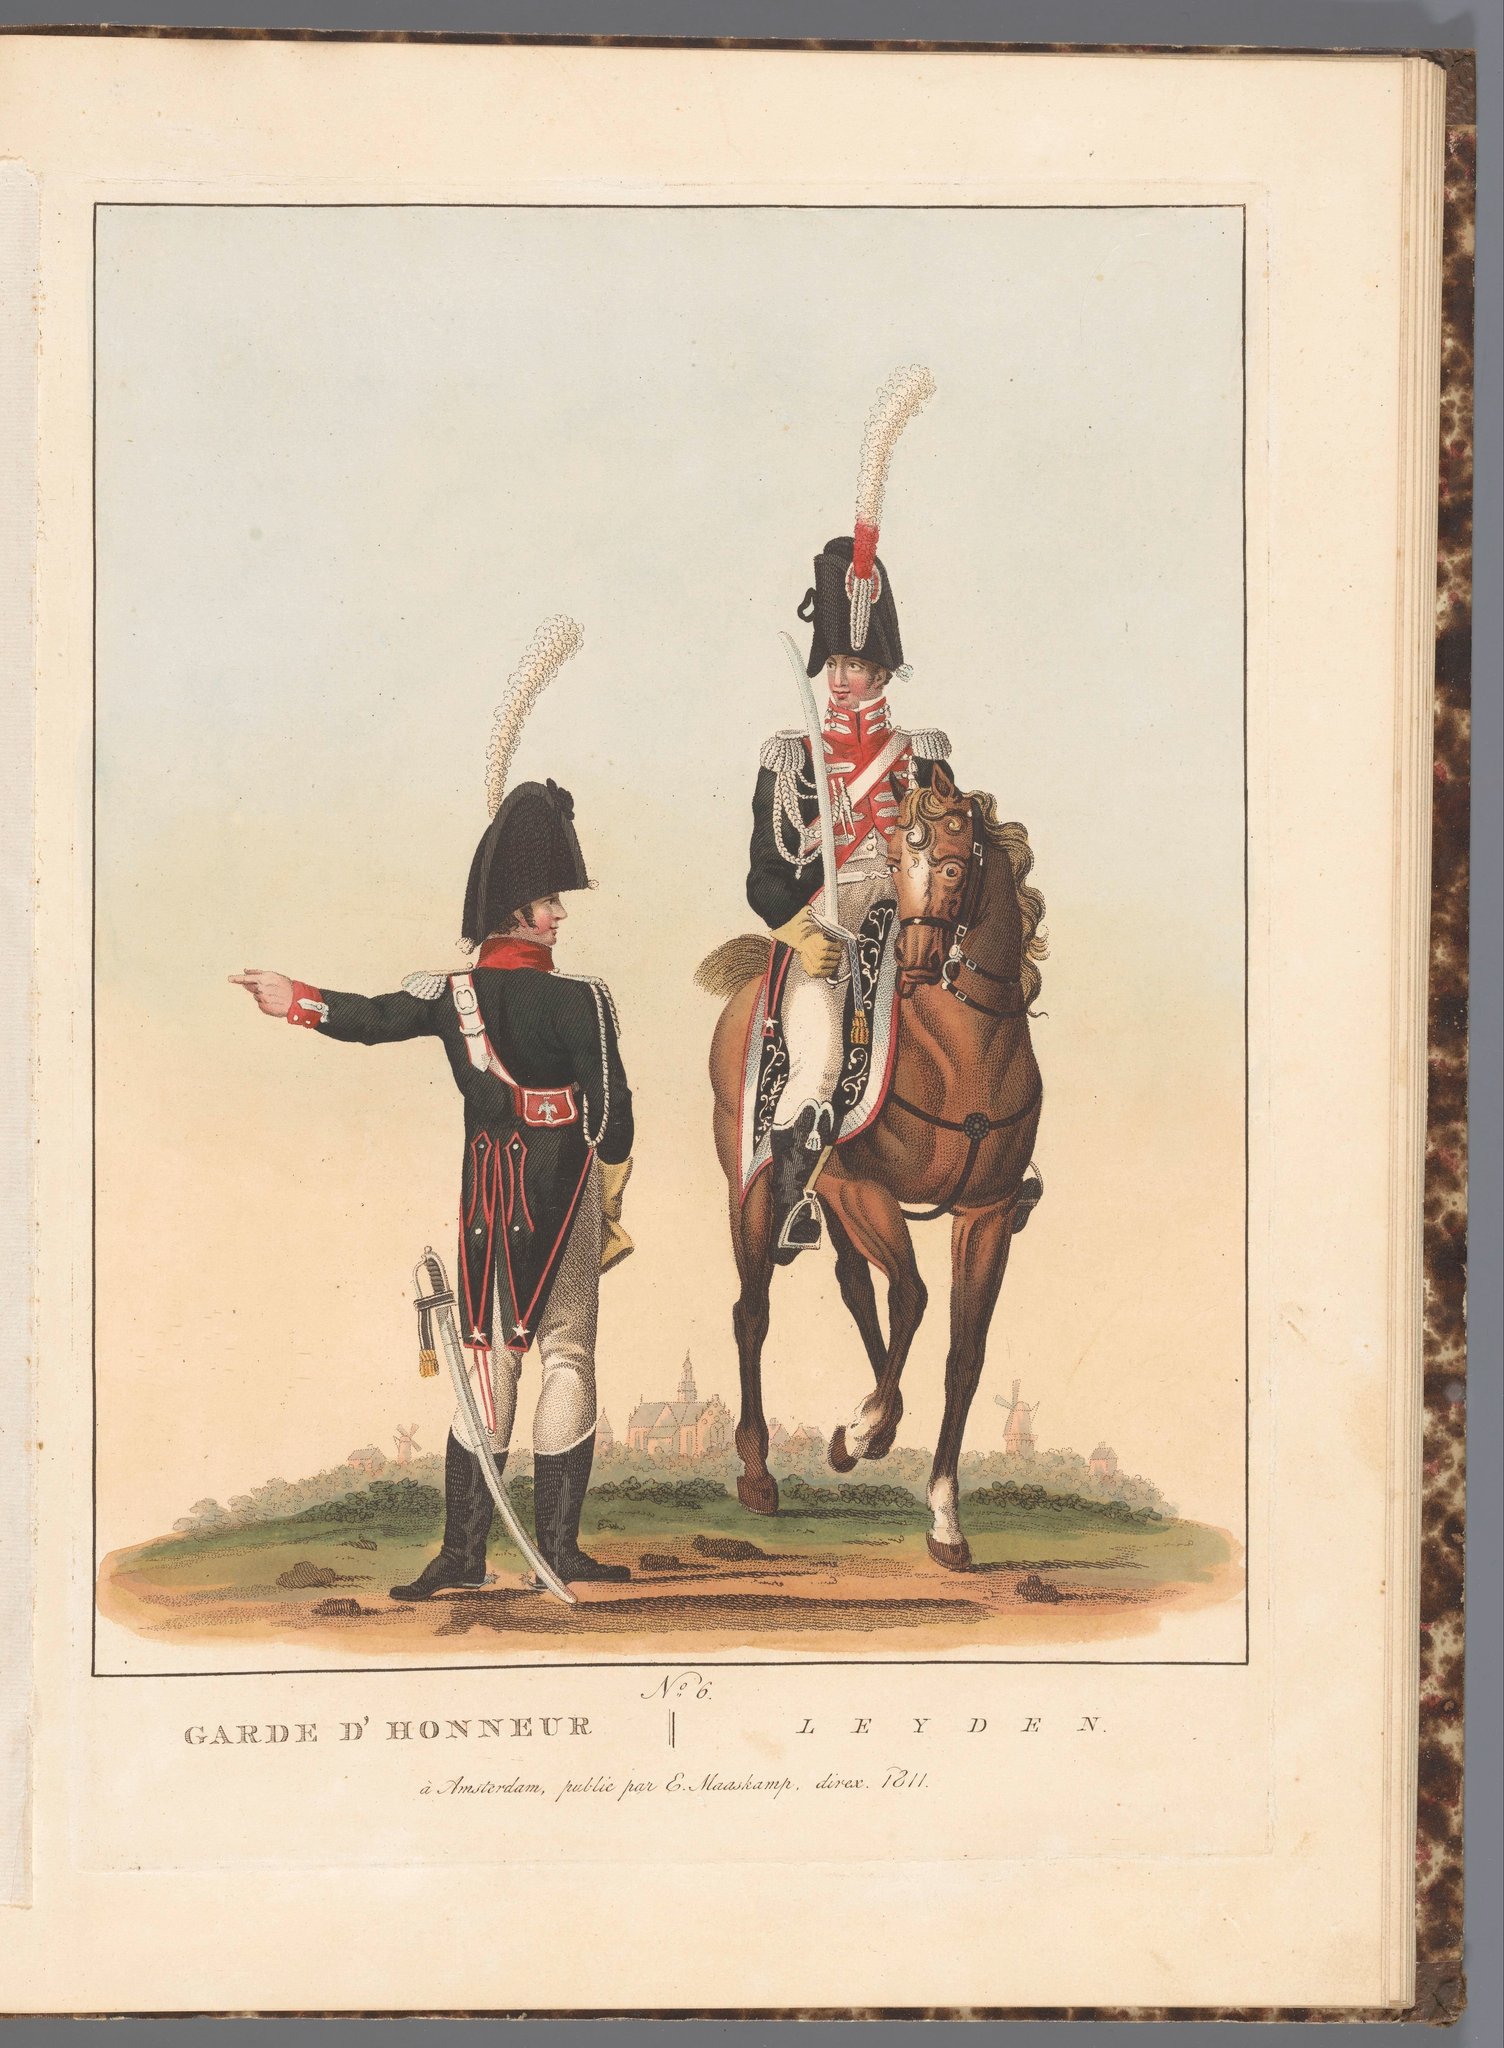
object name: print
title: No. 6 Garde d'Honneur / Leyden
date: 1811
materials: paper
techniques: etching, hand coloring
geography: amsterdam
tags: napoleon i (emperor of the french), guard of honour, (military) uniforms, leiden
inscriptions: date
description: Twee leden van de cavalerie en de infanterie van de erewacht te Leiden. Onderdeel van het plaatwerk met twaalf platen van de verschillende uniformen van de erewachten in de zeven Nederlandse departementen, opgericht voor het bezoek van Napoleon Bonaparte aan Nederland in 1811.